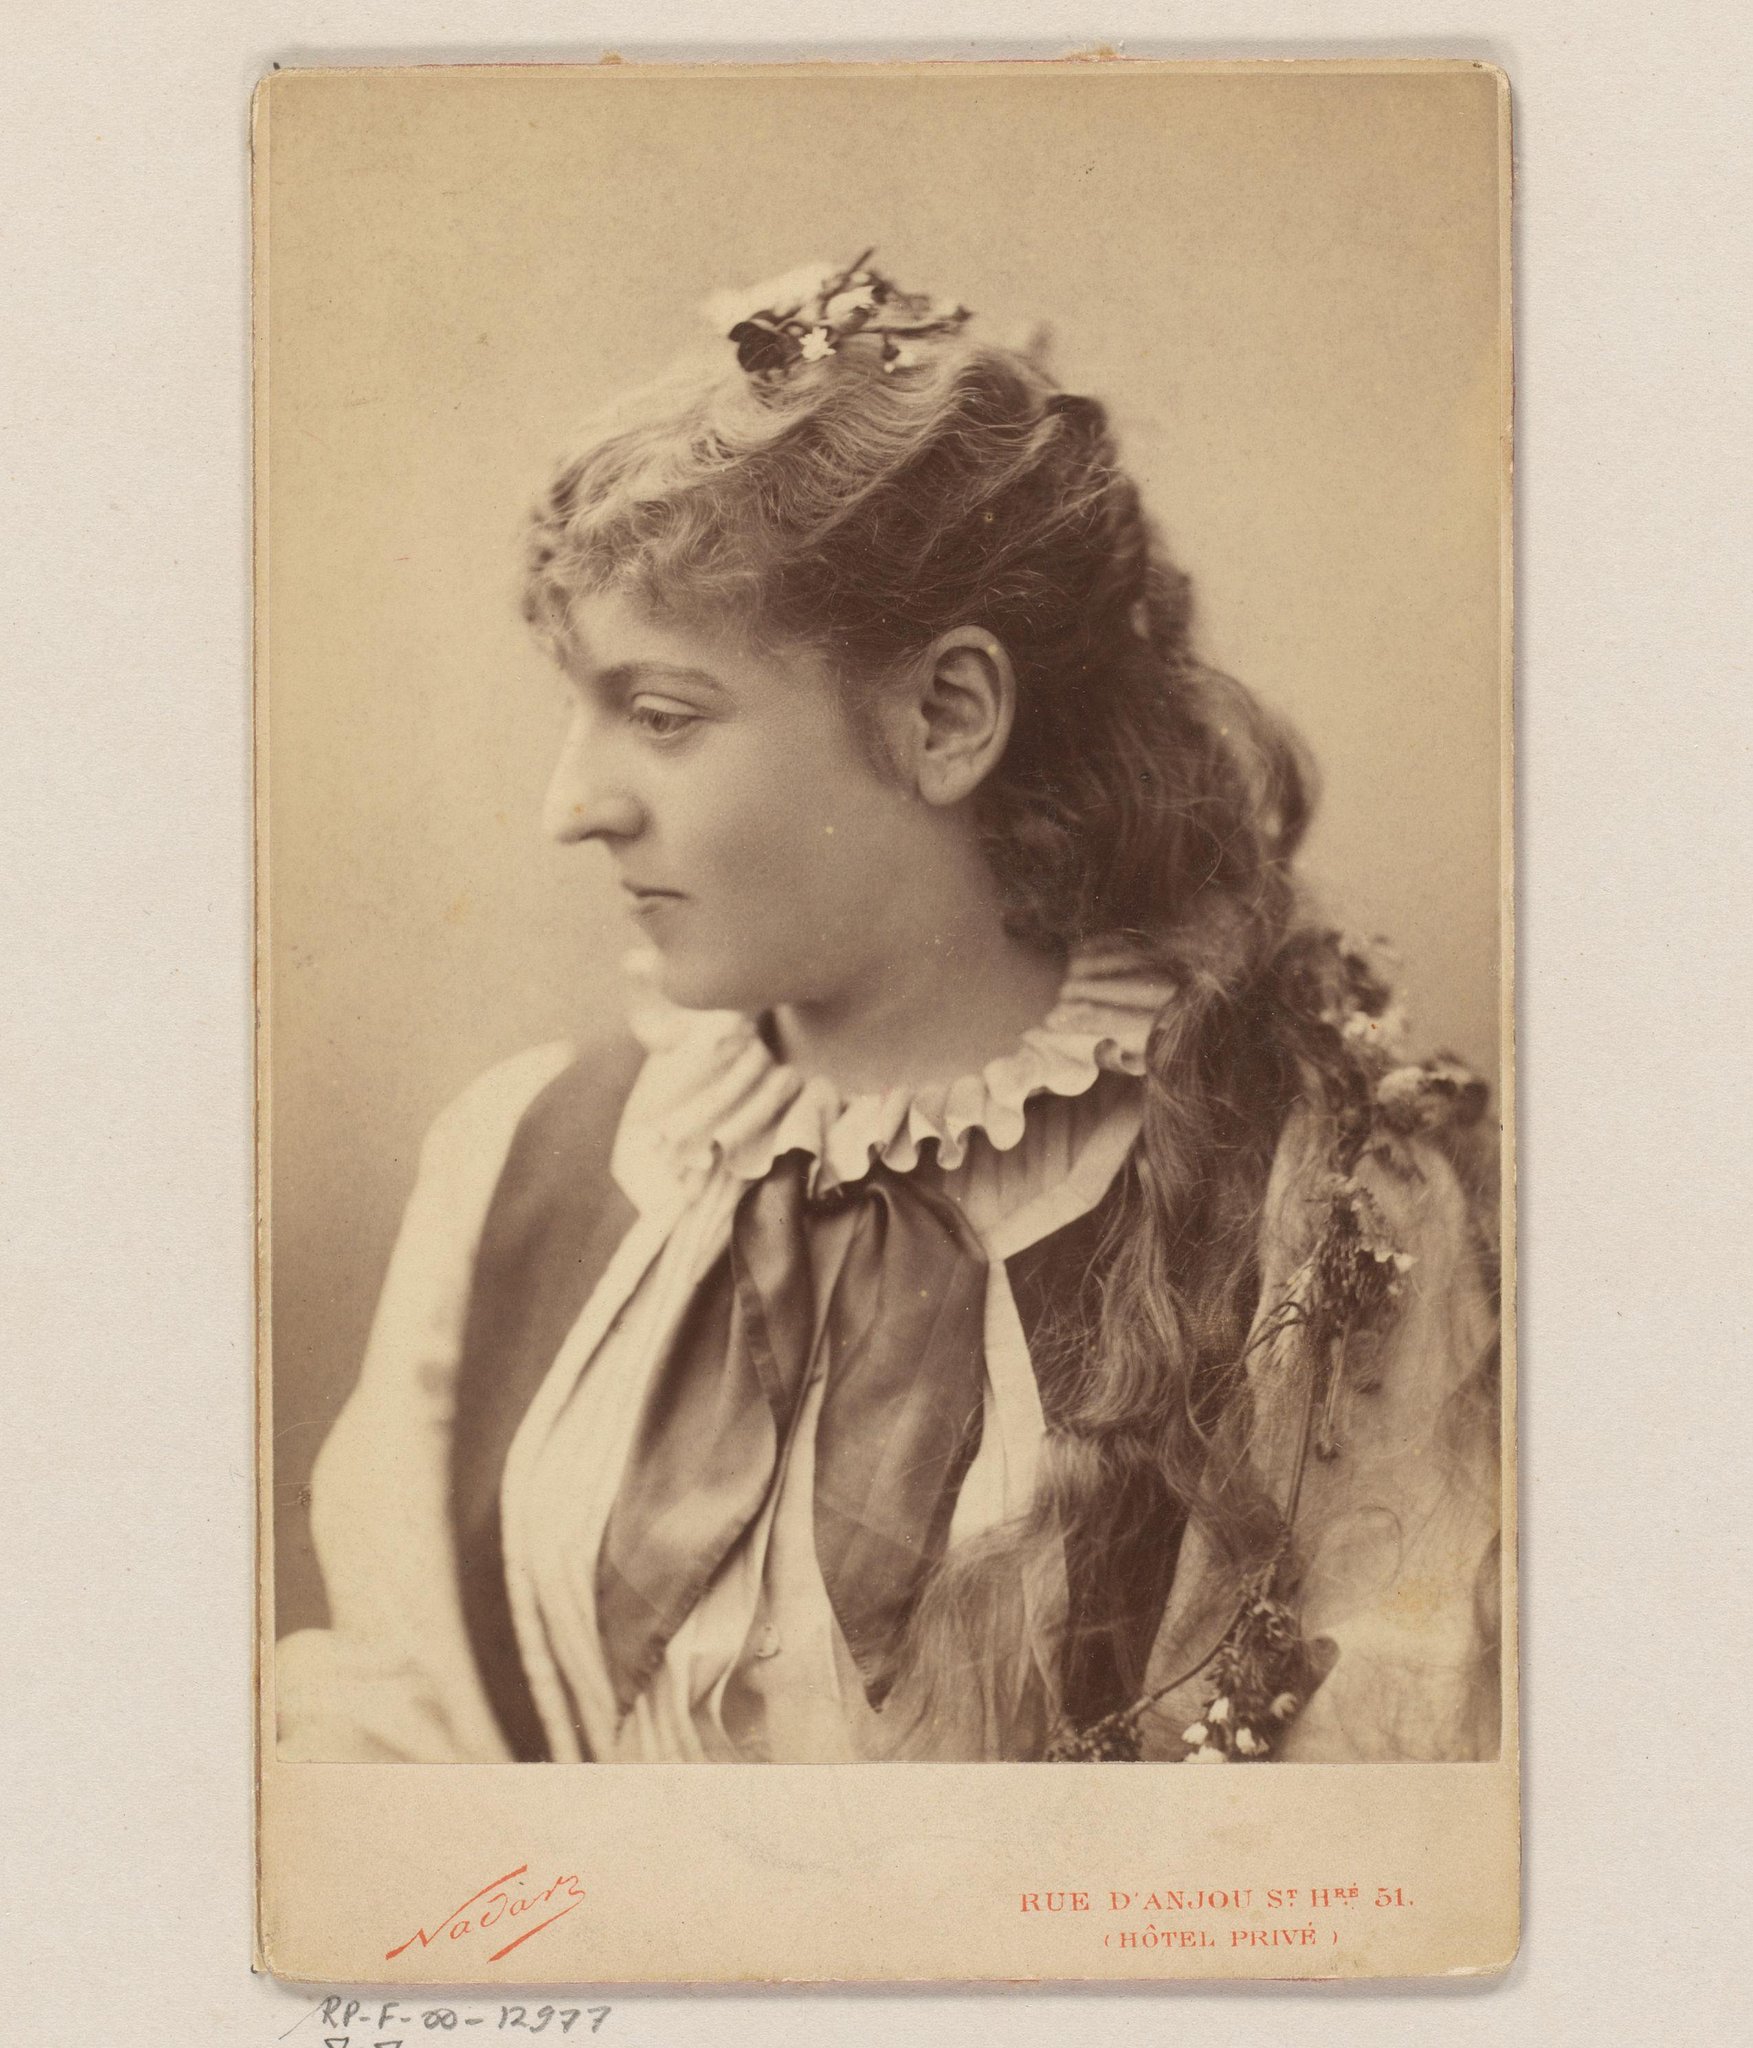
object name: cabinet photograph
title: Portret van Suzanne Reichemberg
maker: félix nadar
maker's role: ballonvaarder, fotograaf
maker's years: 1820-1910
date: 1878-1885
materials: cardboard, paper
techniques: albumen print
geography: paris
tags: historical persons - bb - woman, portrait of actor, actress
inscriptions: inscription: ‘Reichemberg’, stamp: ‘Maison Martinet/ Albert/ Hautecoeur/ 12, Bould des Capucines’, inscription: ‘Médaille d'Or/ Exposition Universelle (...) (Anciennement Boulevart des Capucines)’, inscription: ‘Reichemberg/ Fr.’